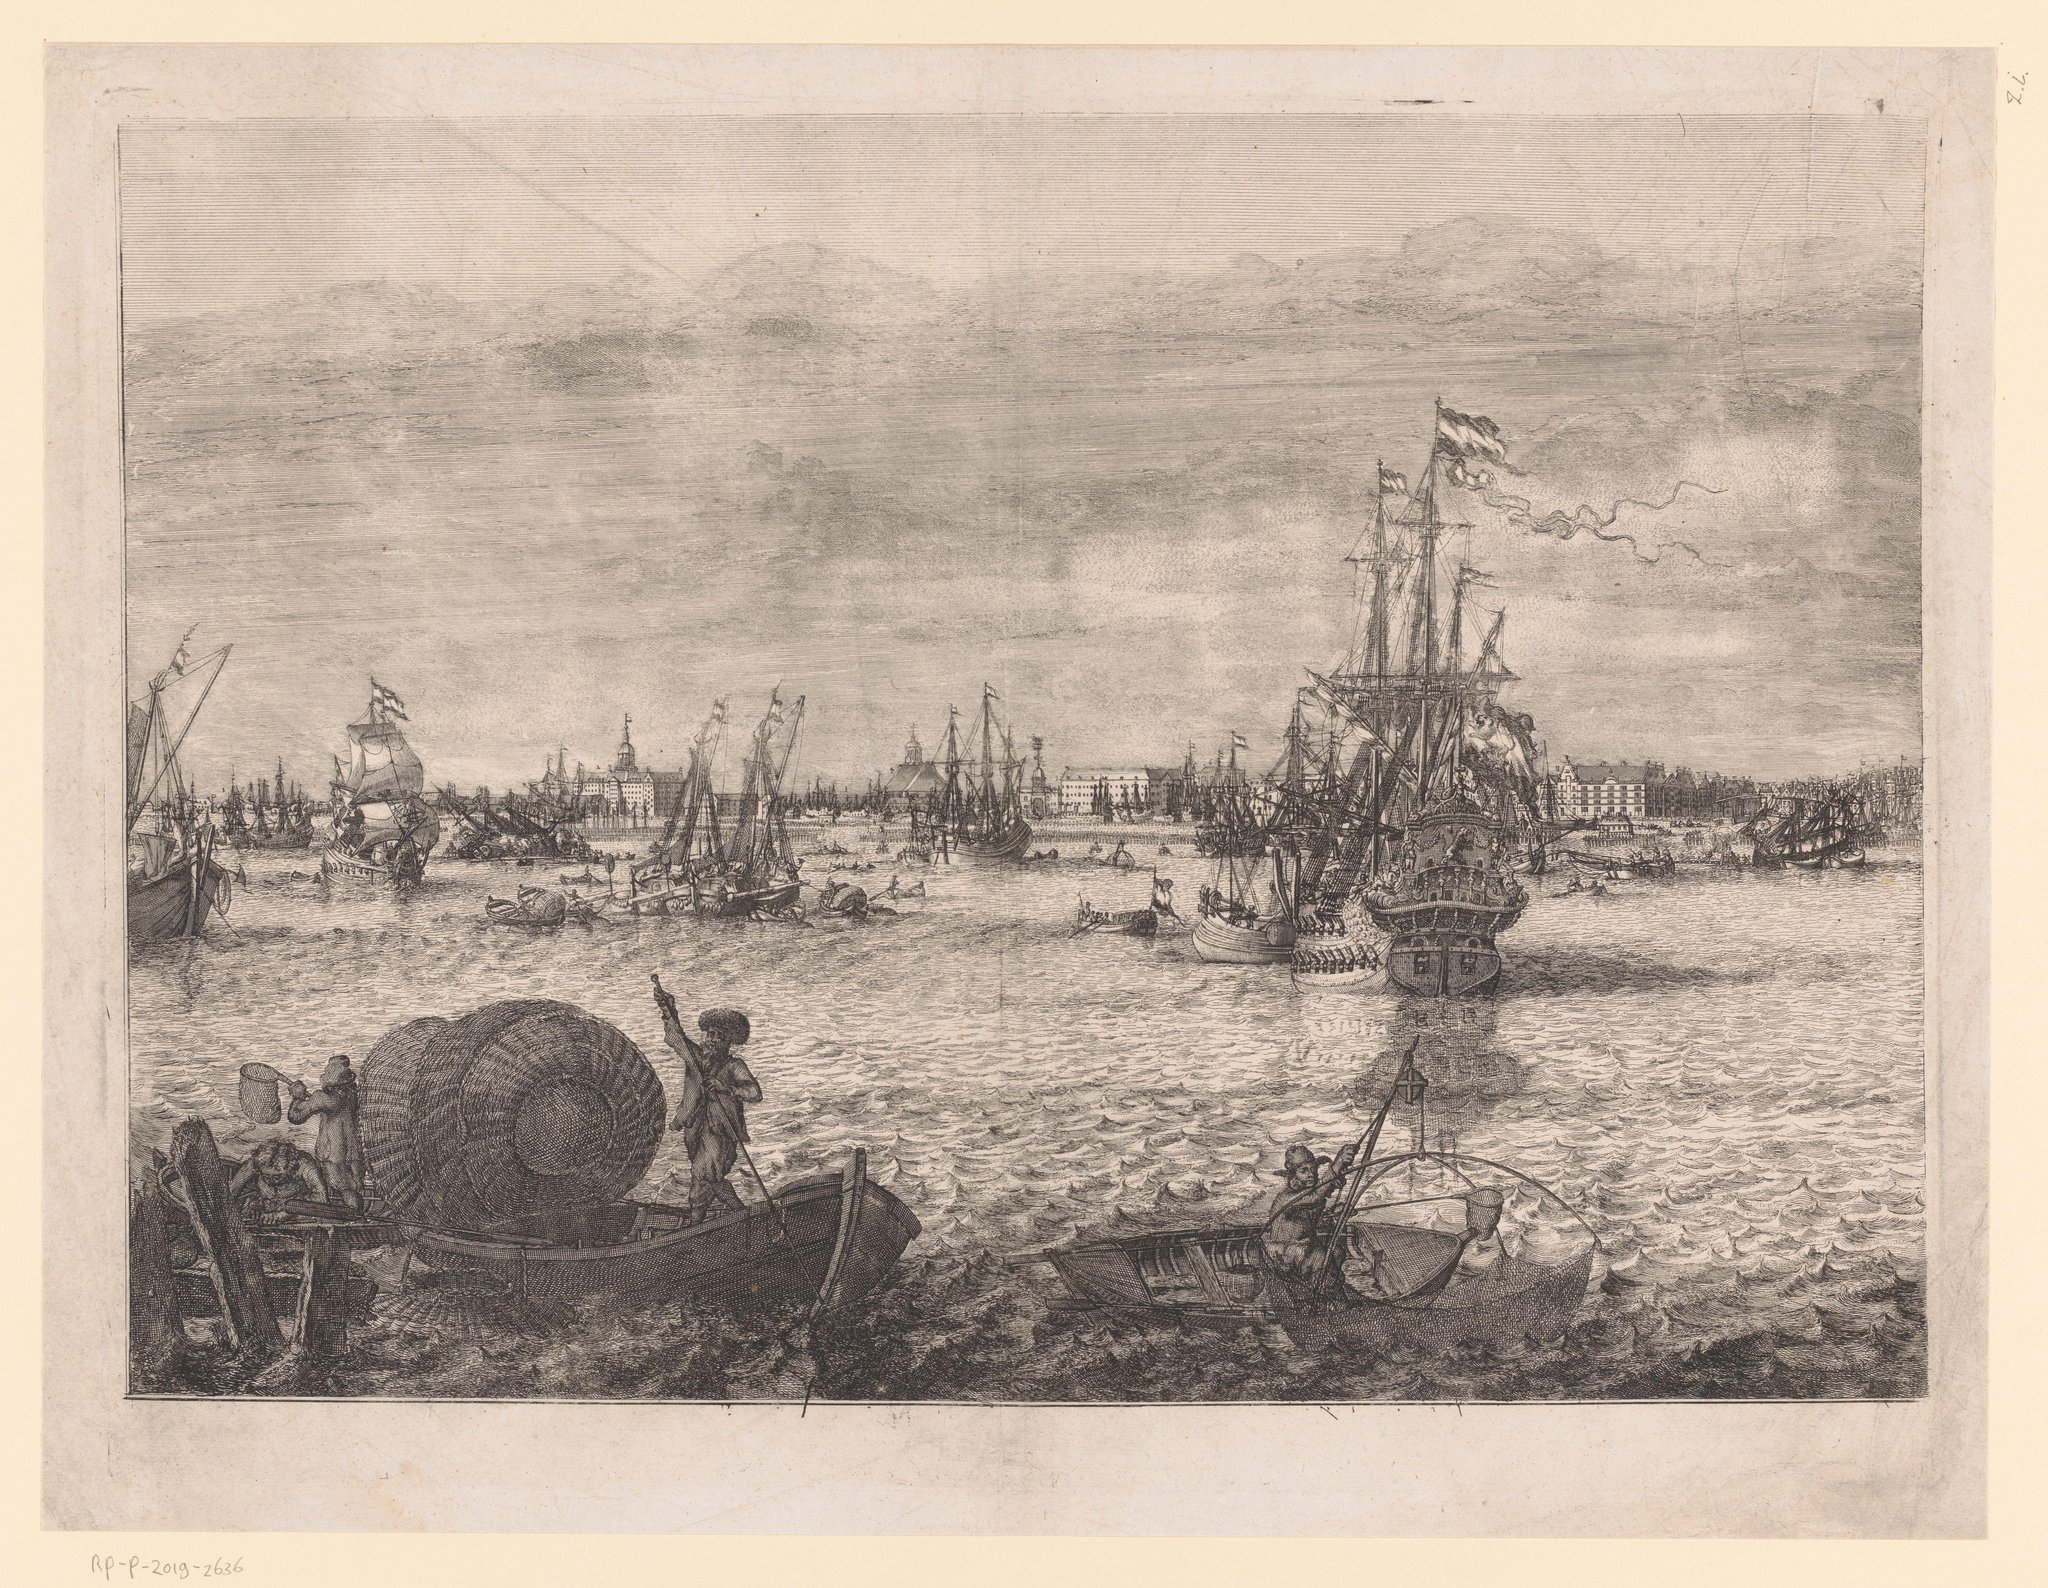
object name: print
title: Gezicht op Amsterdam vanaf het IJ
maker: johannes kip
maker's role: print maker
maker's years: 1652-1722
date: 1662-1722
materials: paper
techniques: etching, roulette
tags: fishing net, ships (in general) - cc - more than one ship, fisherman, prospect of city, town panorama, silhouette of city (+ city(-scape) with figures, staffage), amsterdam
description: Prent vormt oorspronkelijk met vijf andere bladen een panorama van Amsterdam.